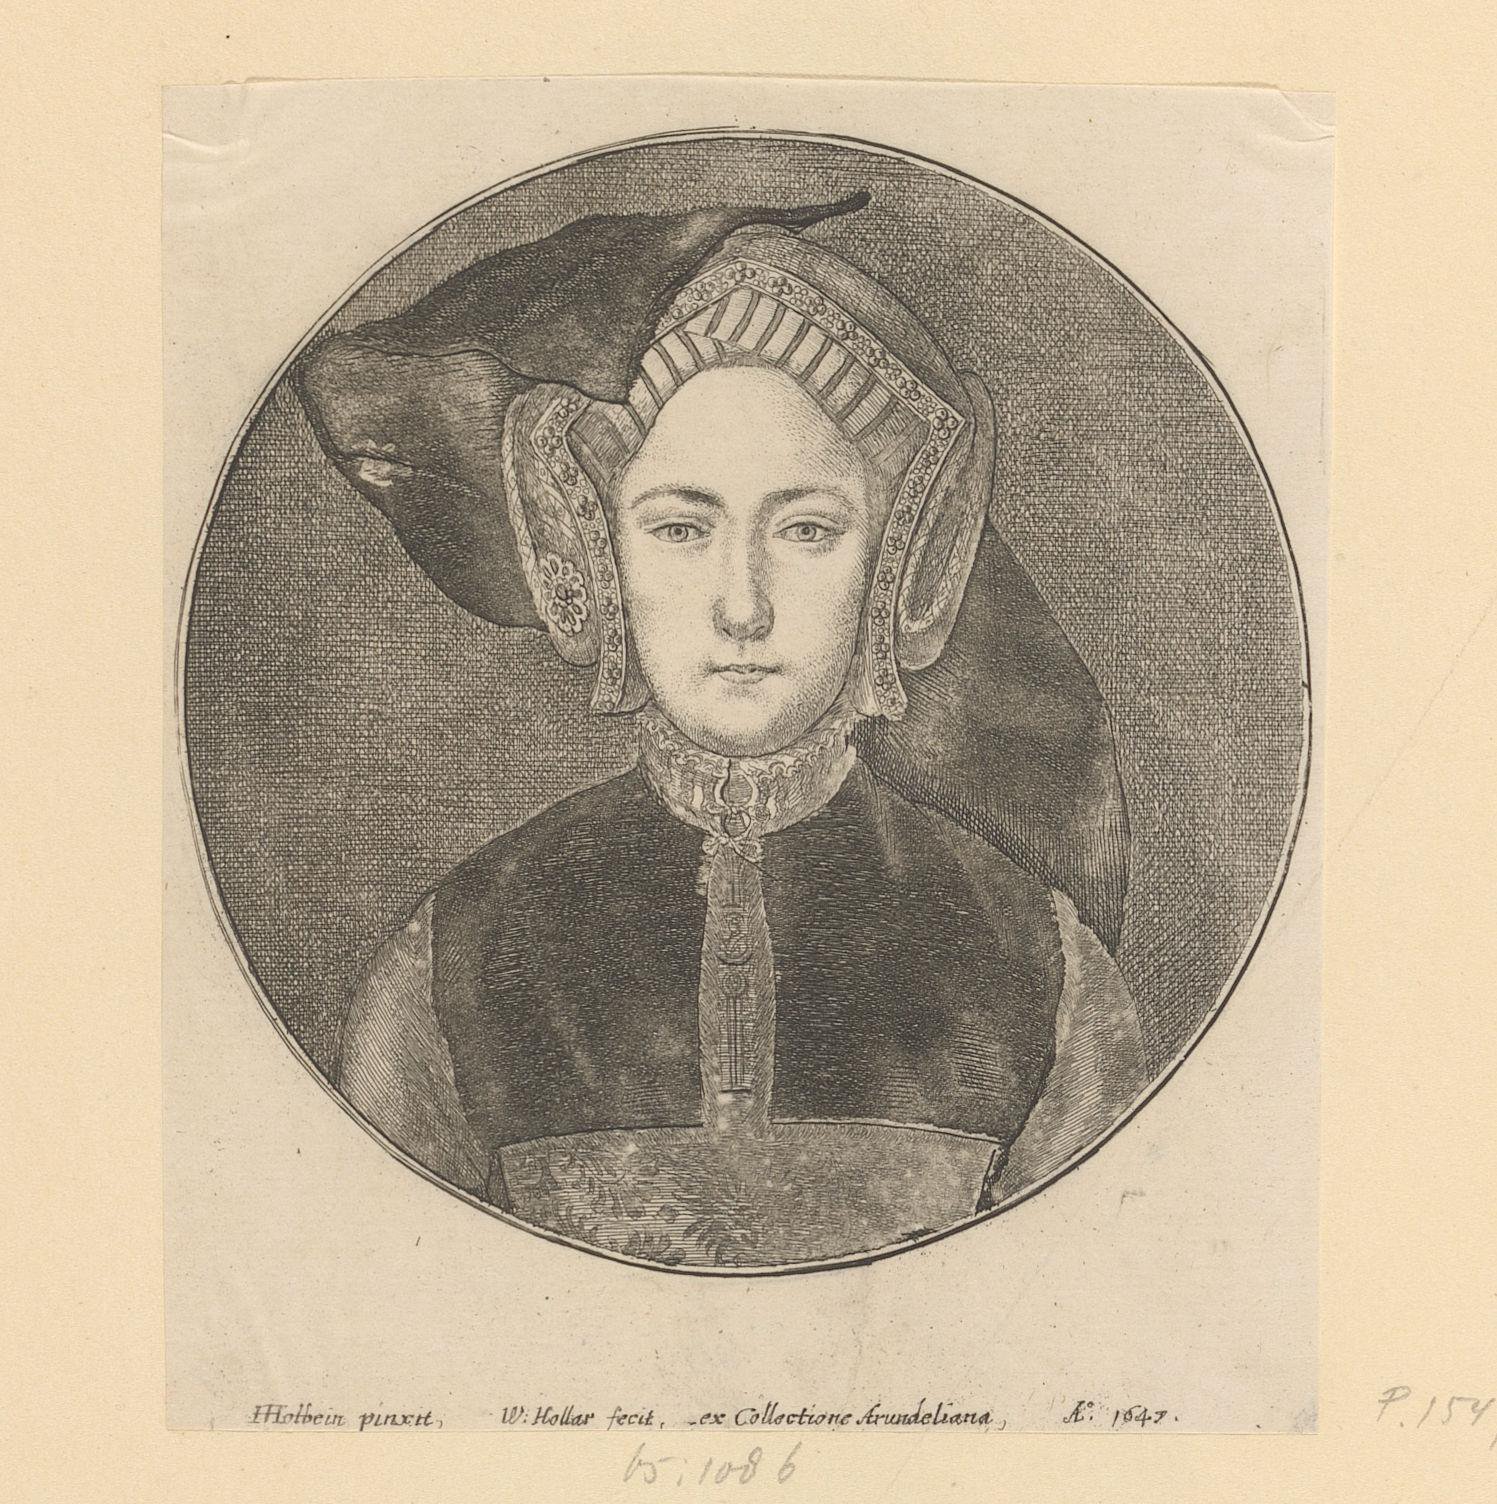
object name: print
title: Portret van een onbekende vrouw met Engelse kap, mogelijk Catharina van Arragon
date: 1647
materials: paper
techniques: etching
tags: historical persons, queen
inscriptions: date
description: Prent maakt mogelijk deel uit van een serie van 200 prenten. Deze serie is onder de titel 'A Collection of two hundred original etchings' voor het eerst uitgegeven door J.M. Greery in 1816.